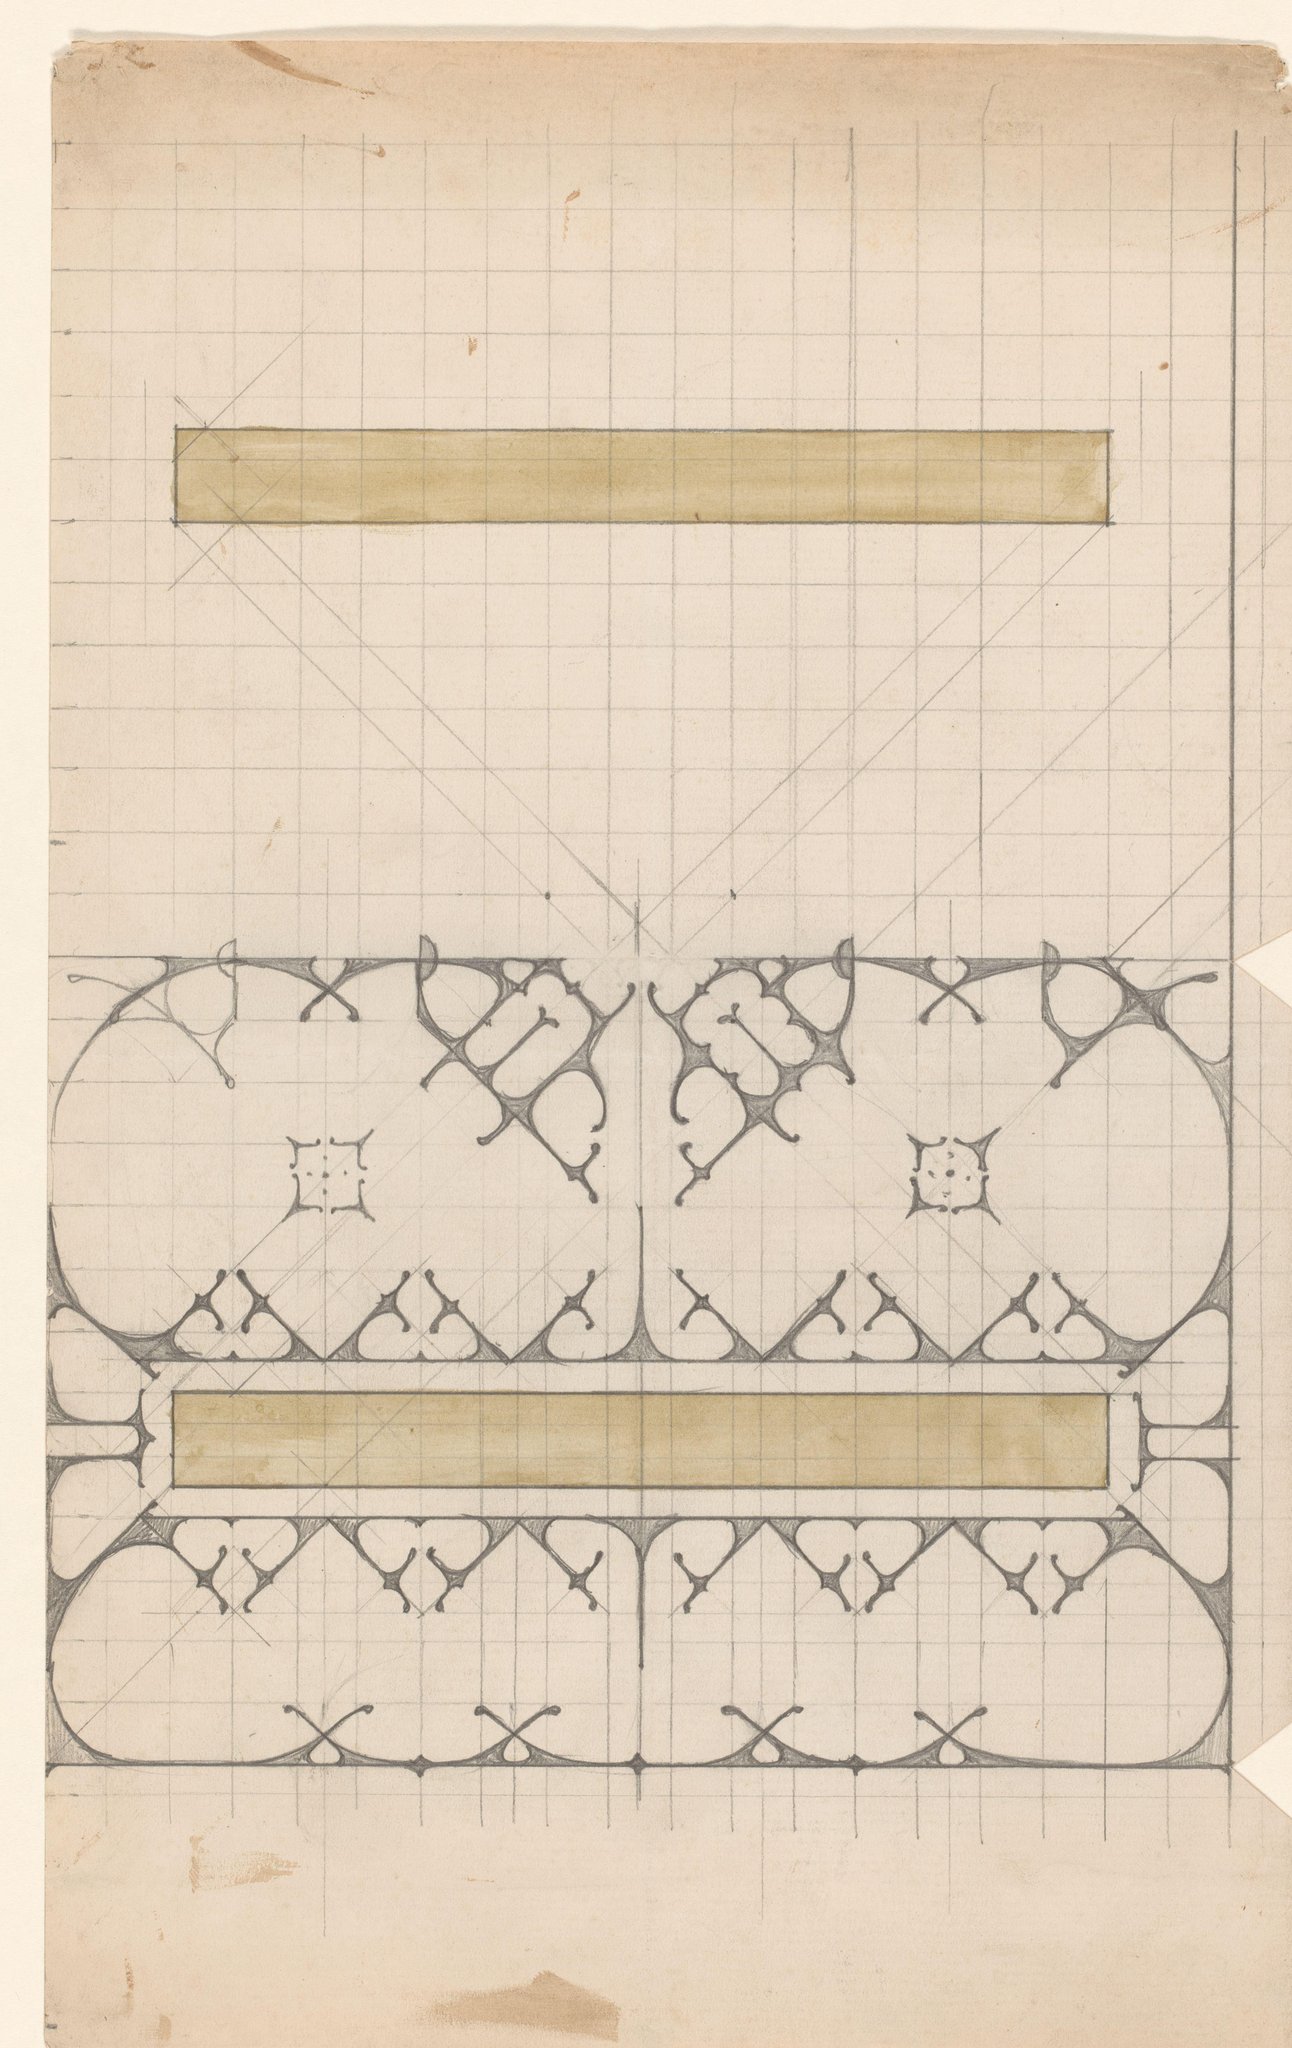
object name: drawing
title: Ontwerp met twee rechthoeken en ornamenten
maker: reinier willem petrus de vries (1874-1953)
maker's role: draughtsman, print maker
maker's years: 1874-1953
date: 1884-1952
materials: paper, pencil, watercolor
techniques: brush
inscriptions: collector's mark: ‘R:MVS.’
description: Ontwerp voor portefeuille-schutbladen. De linten zouden moeten lopen aan de binnenzijde over de platten waar stroken zijn getekend.